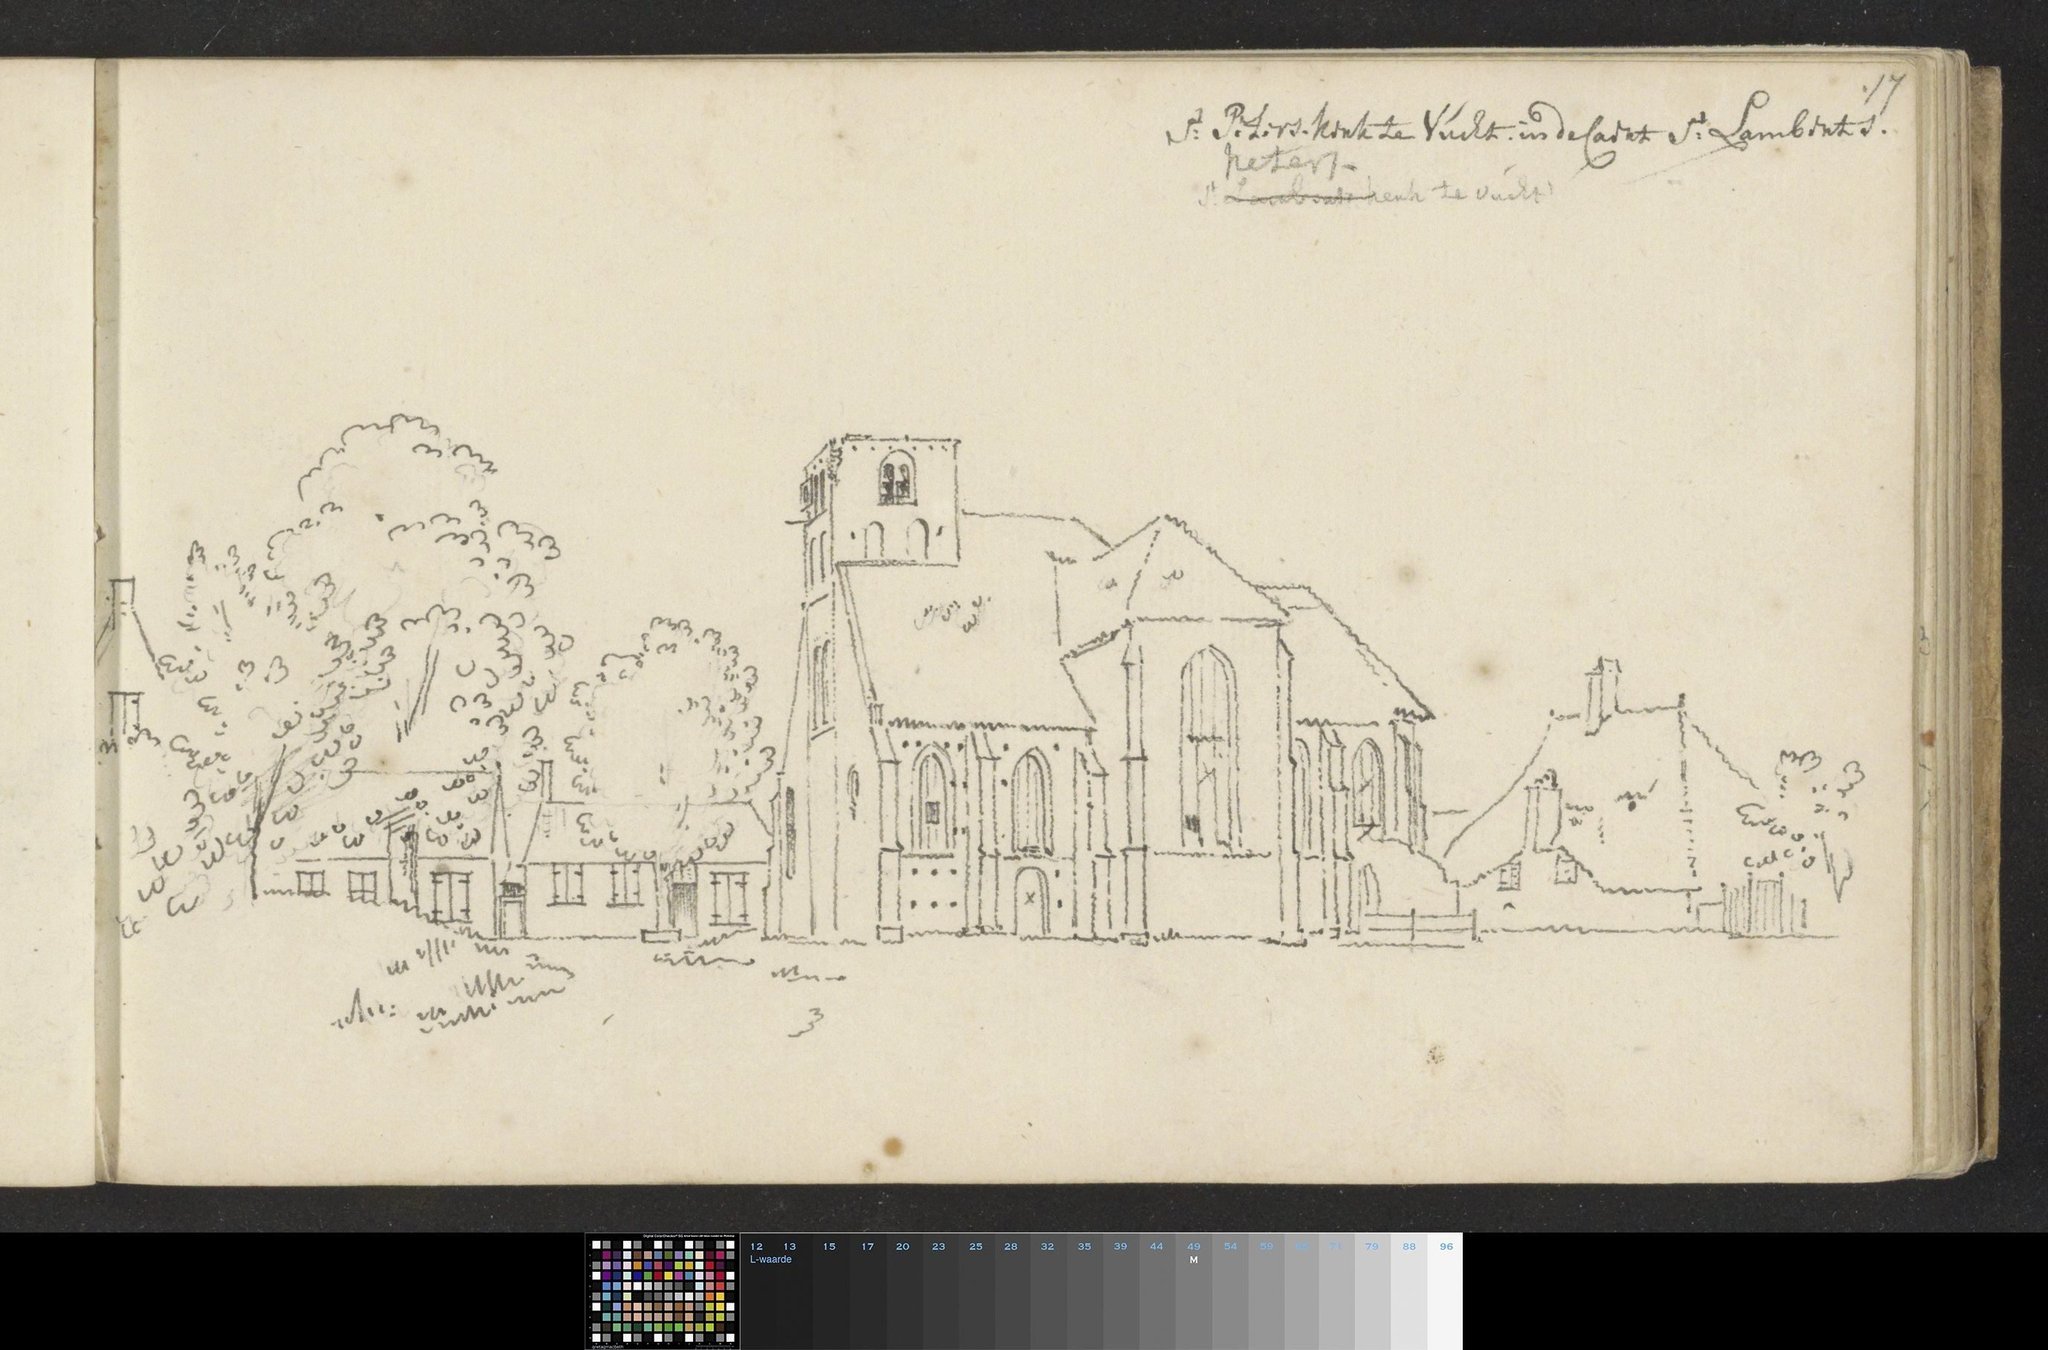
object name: sketchbook leaf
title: St. Peterskerk te Vught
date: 1701-1759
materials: ink, paper, pencil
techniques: brush, pen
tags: prospect of village, silhouette of village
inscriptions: annotation: ‘S: Petersker te Vucht in de[...] S: Lambertus.’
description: Blad 17 recto uit een schetsboek met 65 bladen.